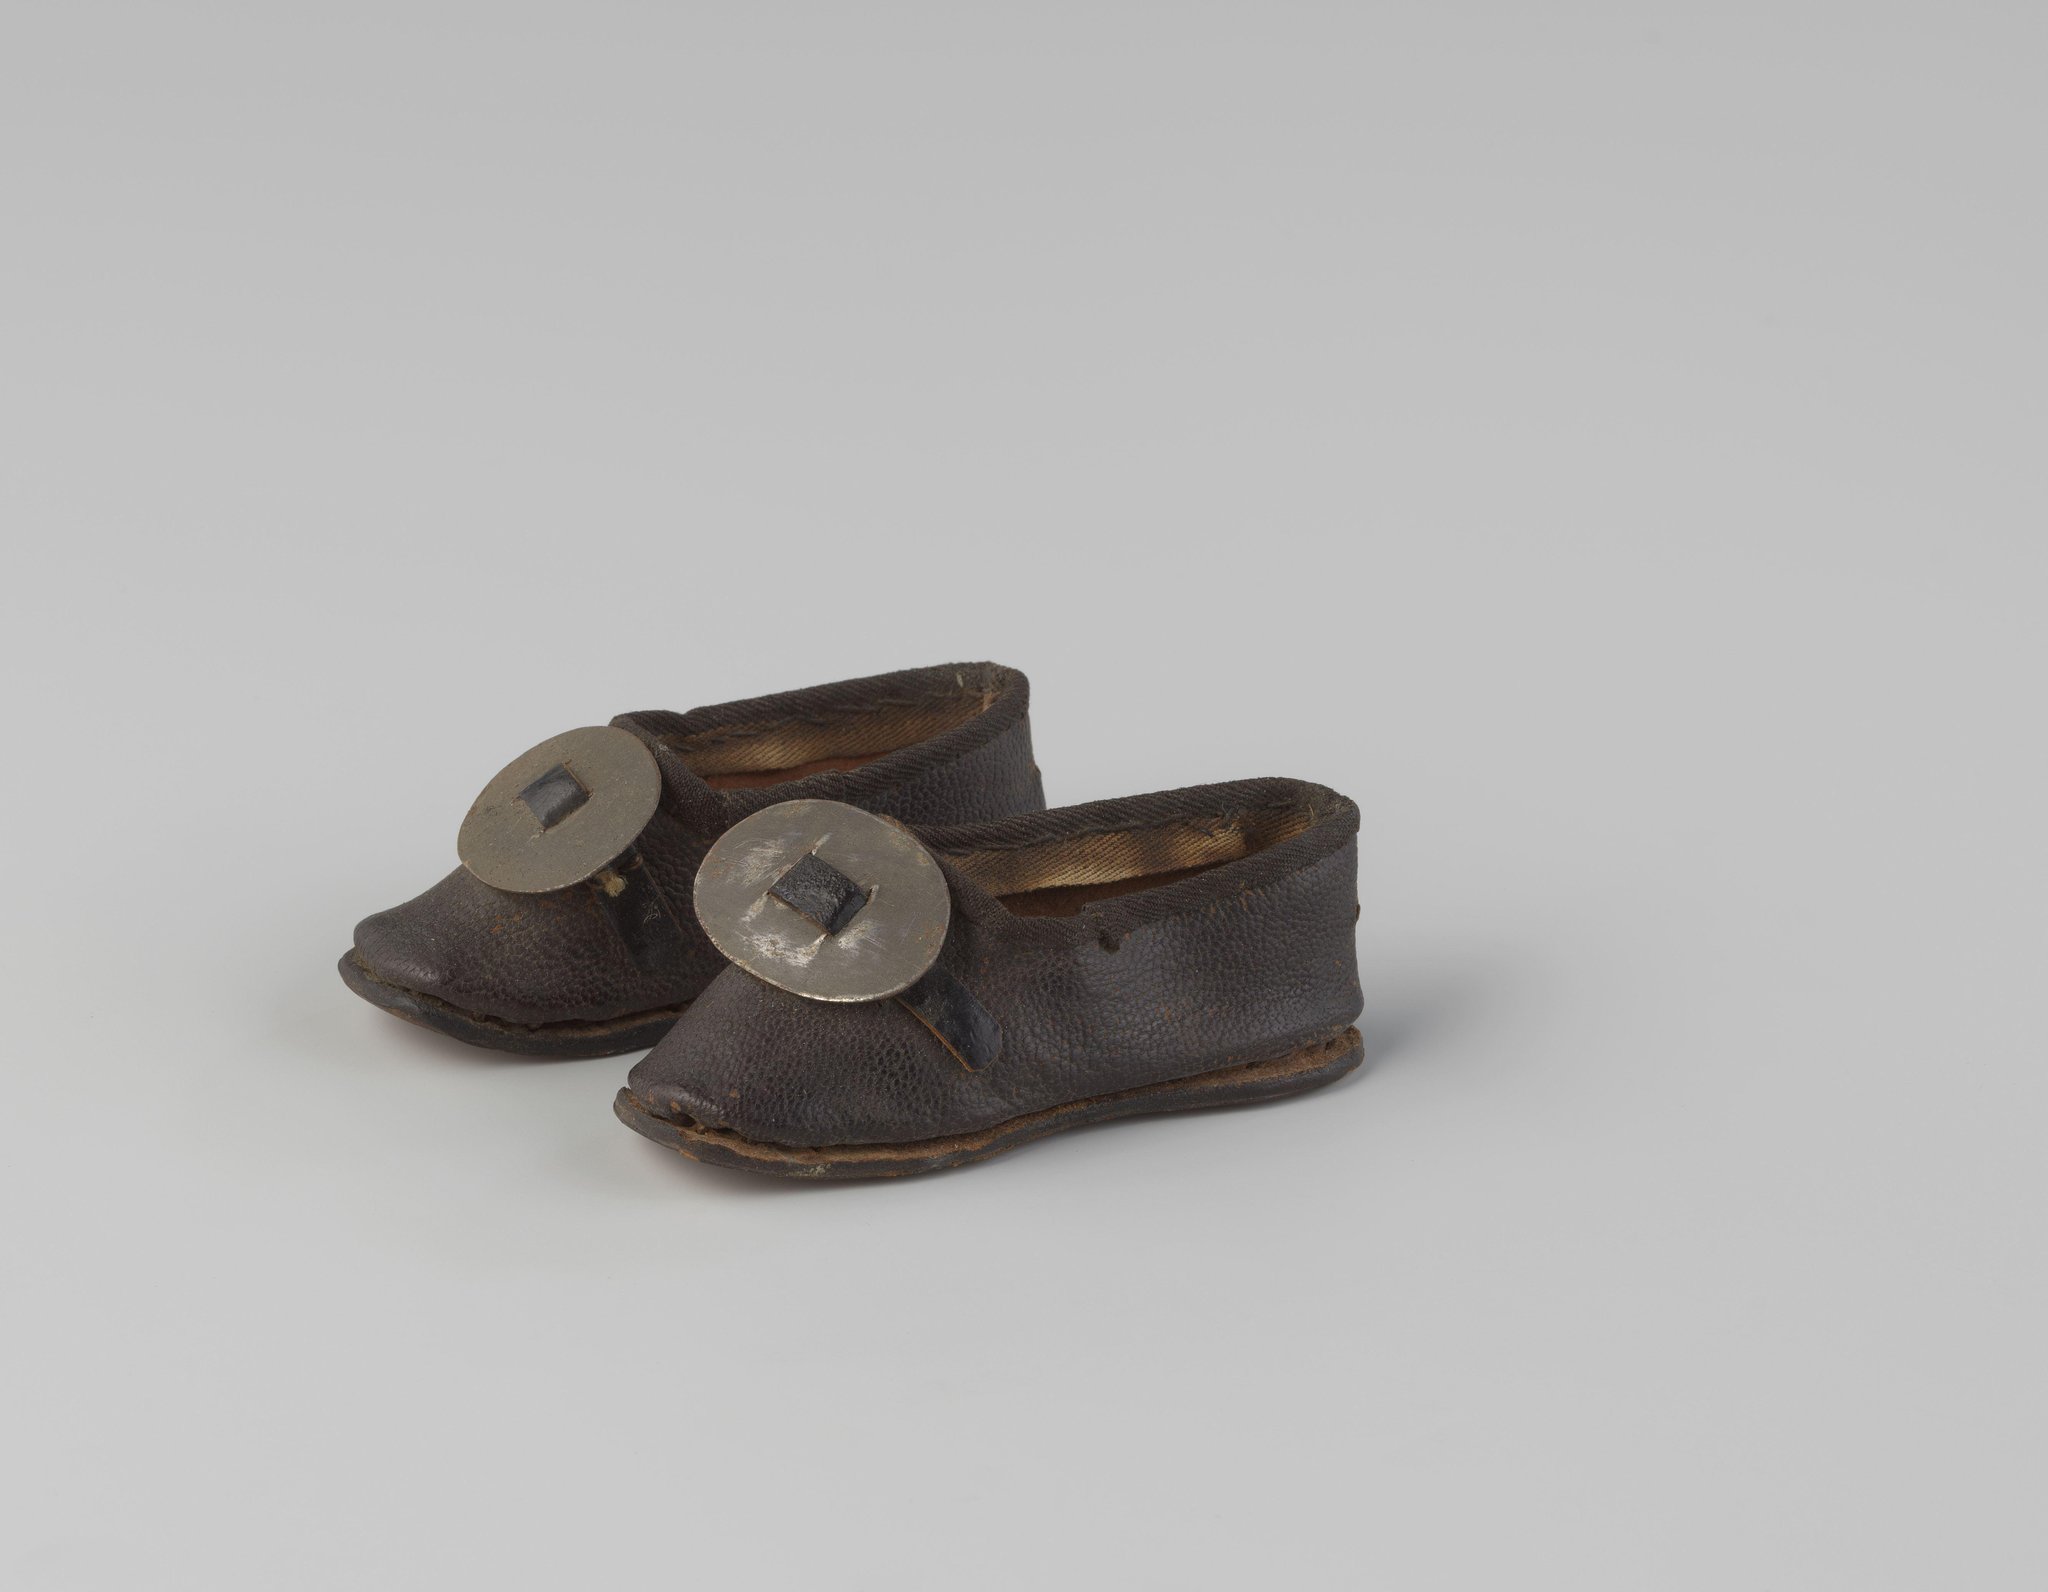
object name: poppenschoen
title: Schoen van zwart leer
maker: Anonymous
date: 1850-1940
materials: leather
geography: europe